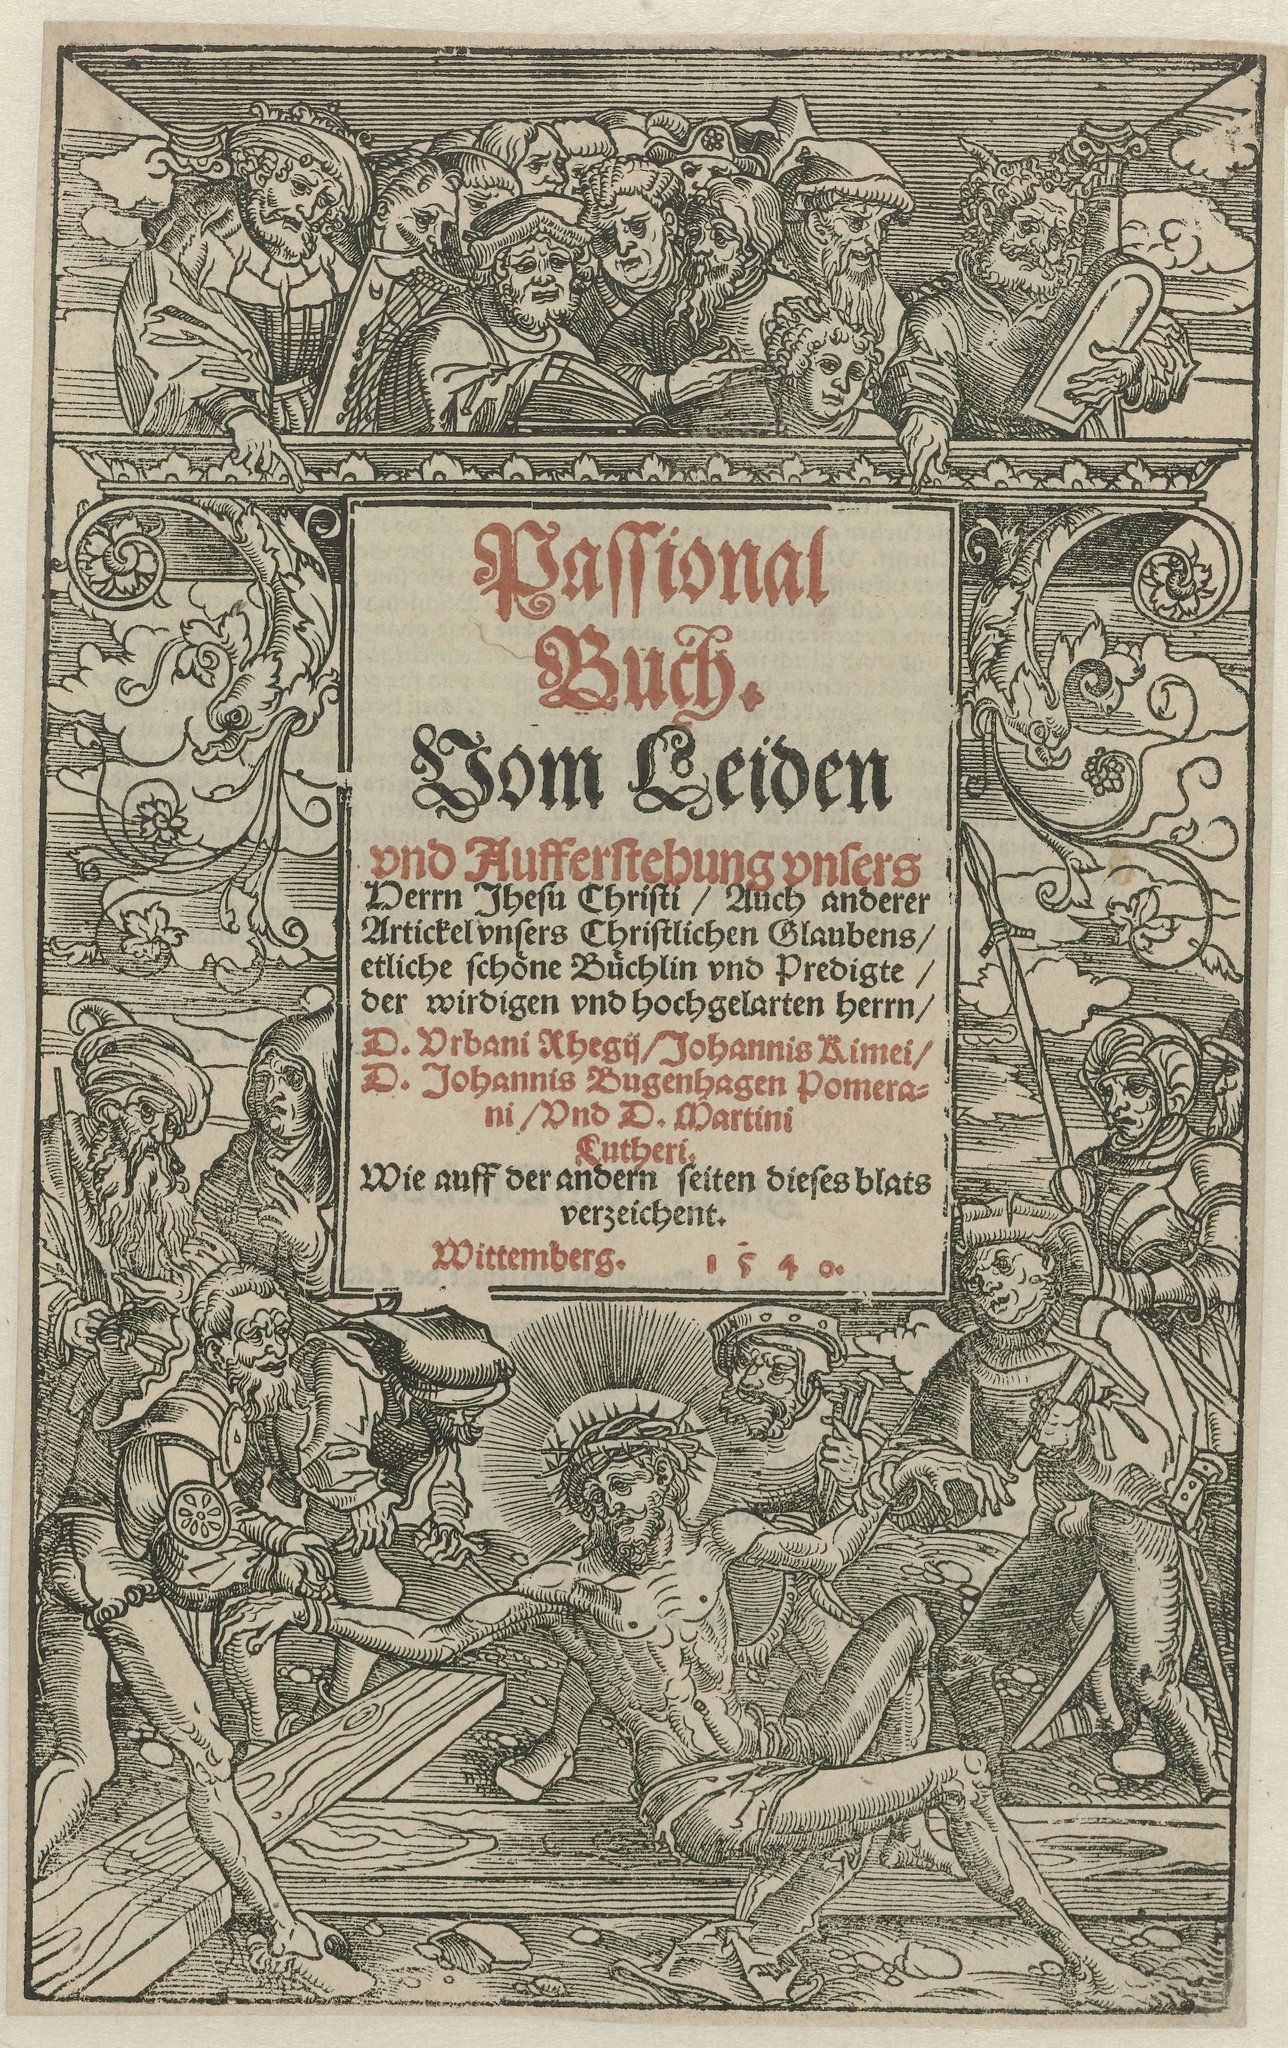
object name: titelprent, frontispice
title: Titelpagina Passional Buch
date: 1540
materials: paper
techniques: woodcut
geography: wittenberg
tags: the crucifixion of christ: christ's death on the cross; golgotha (matthew 27:45-58; mark 15:33-45; luke 23:44-52; john 19:25-38)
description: Titelpagina van het Passional Buch met in het midden cartouche met titeltekst. Daarboven een groep profeten waaronder links koning David en rechts Mozes met de Tafelen der Wet. In de onderste zone wordt Christus aan het kruis genageld. Links en rechts van hem Romeinse soldaten en schriftgeleerden.